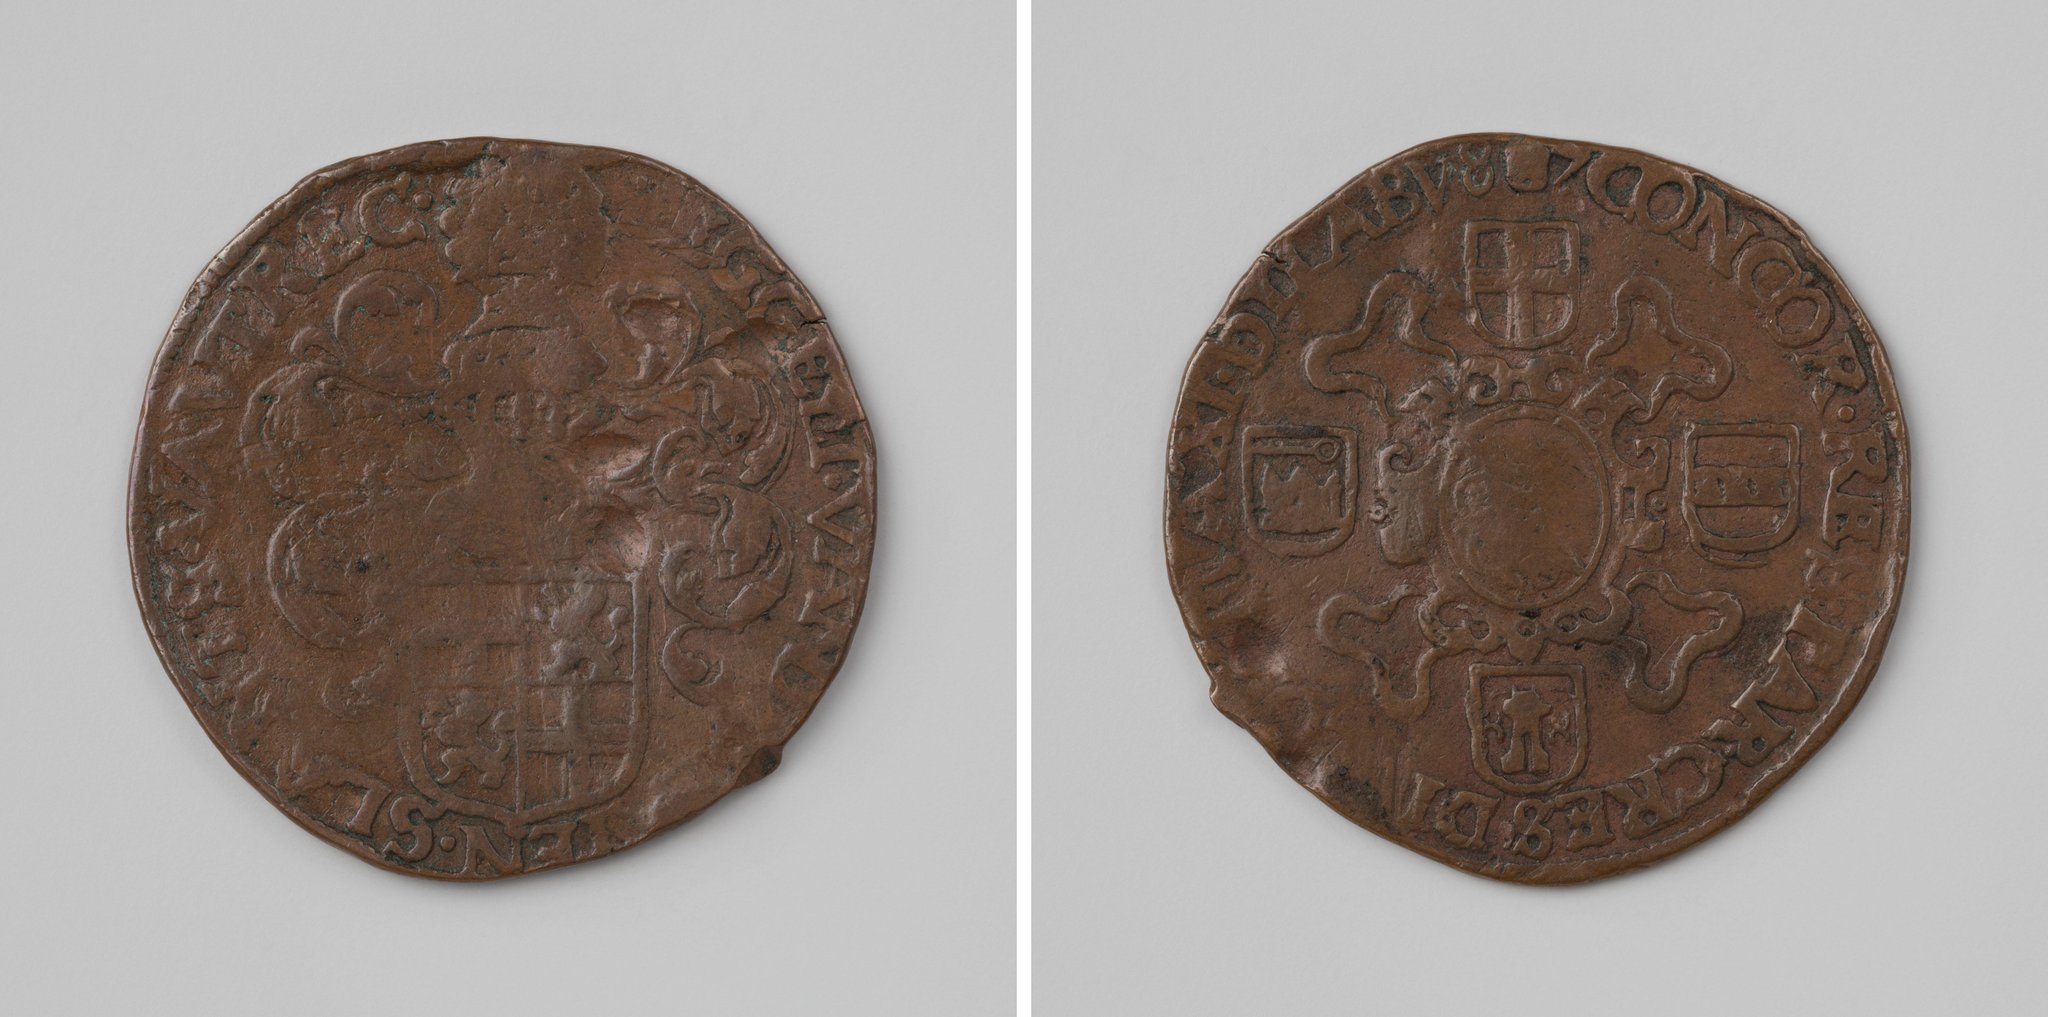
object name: jeton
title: Staten van Utrecht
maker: Anonymous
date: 1587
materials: copper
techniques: striking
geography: utrecht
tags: utrecht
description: Koperen penning. Voorzijde: gehelmd wapenschild onder vaas met bloemen binnen omschrift. Keerzijde: wapenschild op versierd cartouche, omgeven door vier wapenschilden binnen omschrift